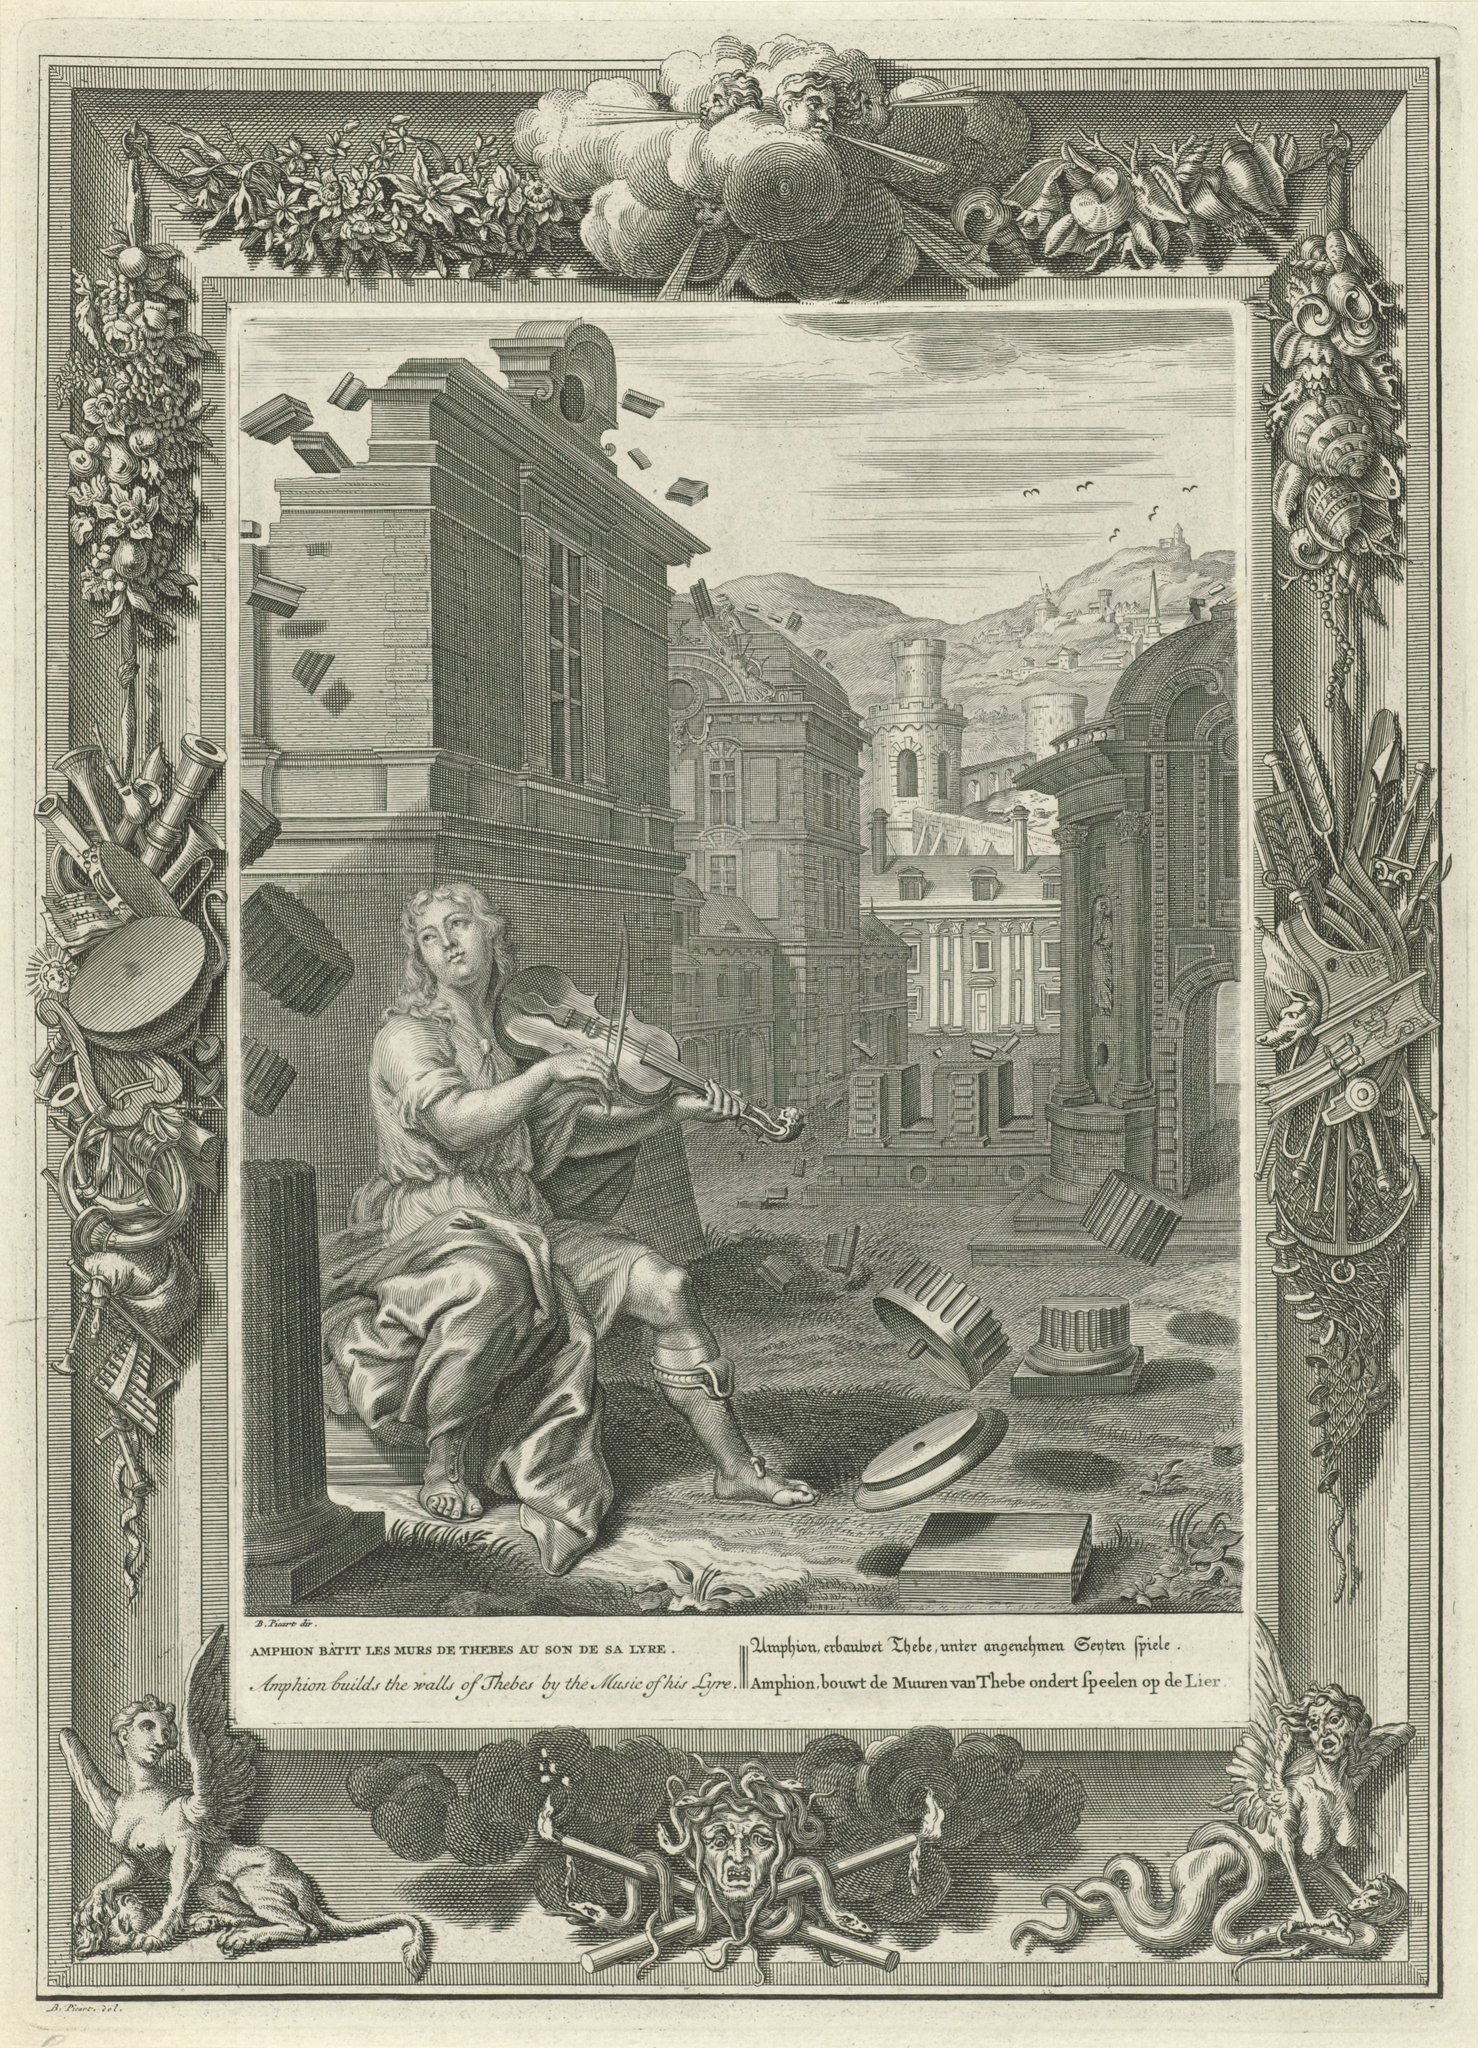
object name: print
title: Amphion bouwt de muren van Thebe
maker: bernard picart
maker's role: draughtsman, print maker, publisher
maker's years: 1673-1733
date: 1733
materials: paper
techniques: engraving, etching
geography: amsterdam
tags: amphion building the walls of thebes (without zethus), scrollwork, strapwork ~ ornament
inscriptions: collector's mark: Lugt 2228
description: Prent ook als illustratie gebruikt in: Beaumarchais, Antoine de La Barre de. Le Temple des Muses: orné de 60 tableaux où sont représentés les événemens les plus remarquables de l'antiquité fabuleuse. Amsterdam: Zacharias Chatelain (II), 1733.